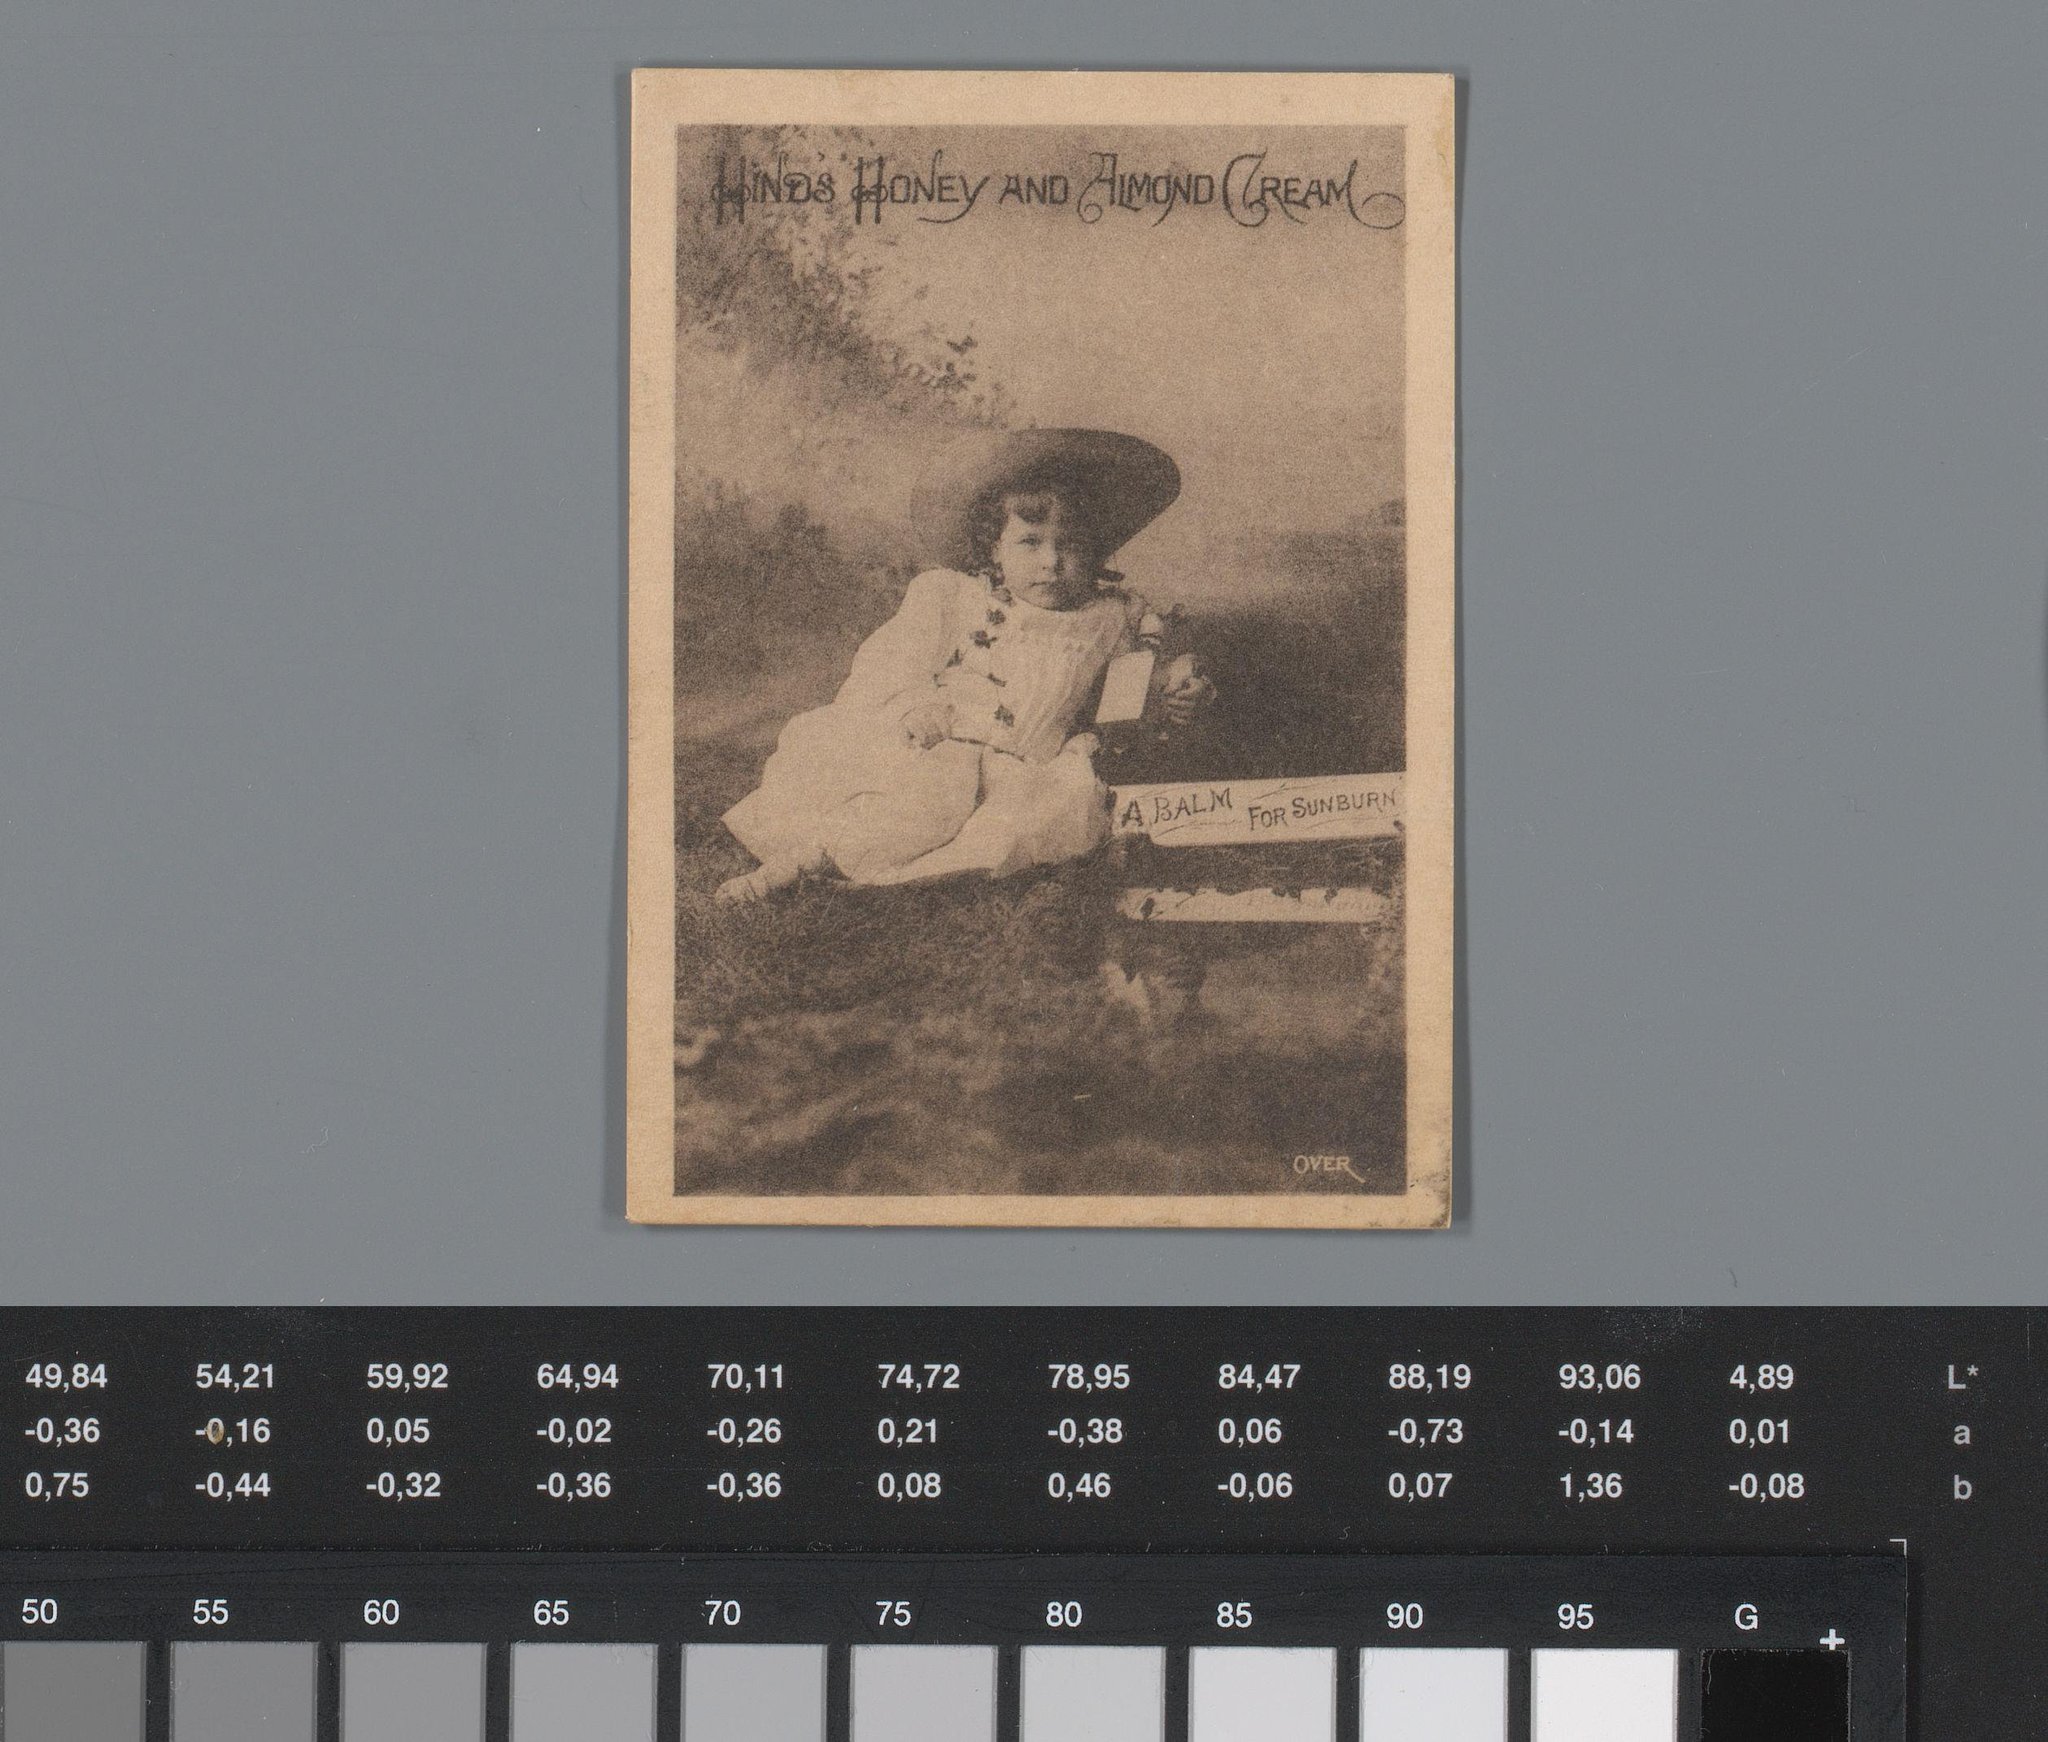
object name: photograph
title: Reclame voor Hinds' honing en amandelcrème, met een portret van een meisje zittend op gras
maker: Anonymous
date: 1865-1940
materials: cardboard, photographic support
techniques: carbon print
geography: portland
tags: advertising, girl (child between toddler and youth), sitting on the ground - aa - female human figure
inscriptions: inscription: ‘HINDS' / HONEY AND ALMOND CREAM, / For Hands, Face, Skin and Complexion. / (...)’, inscription: ‘A Balm for Sunburn’